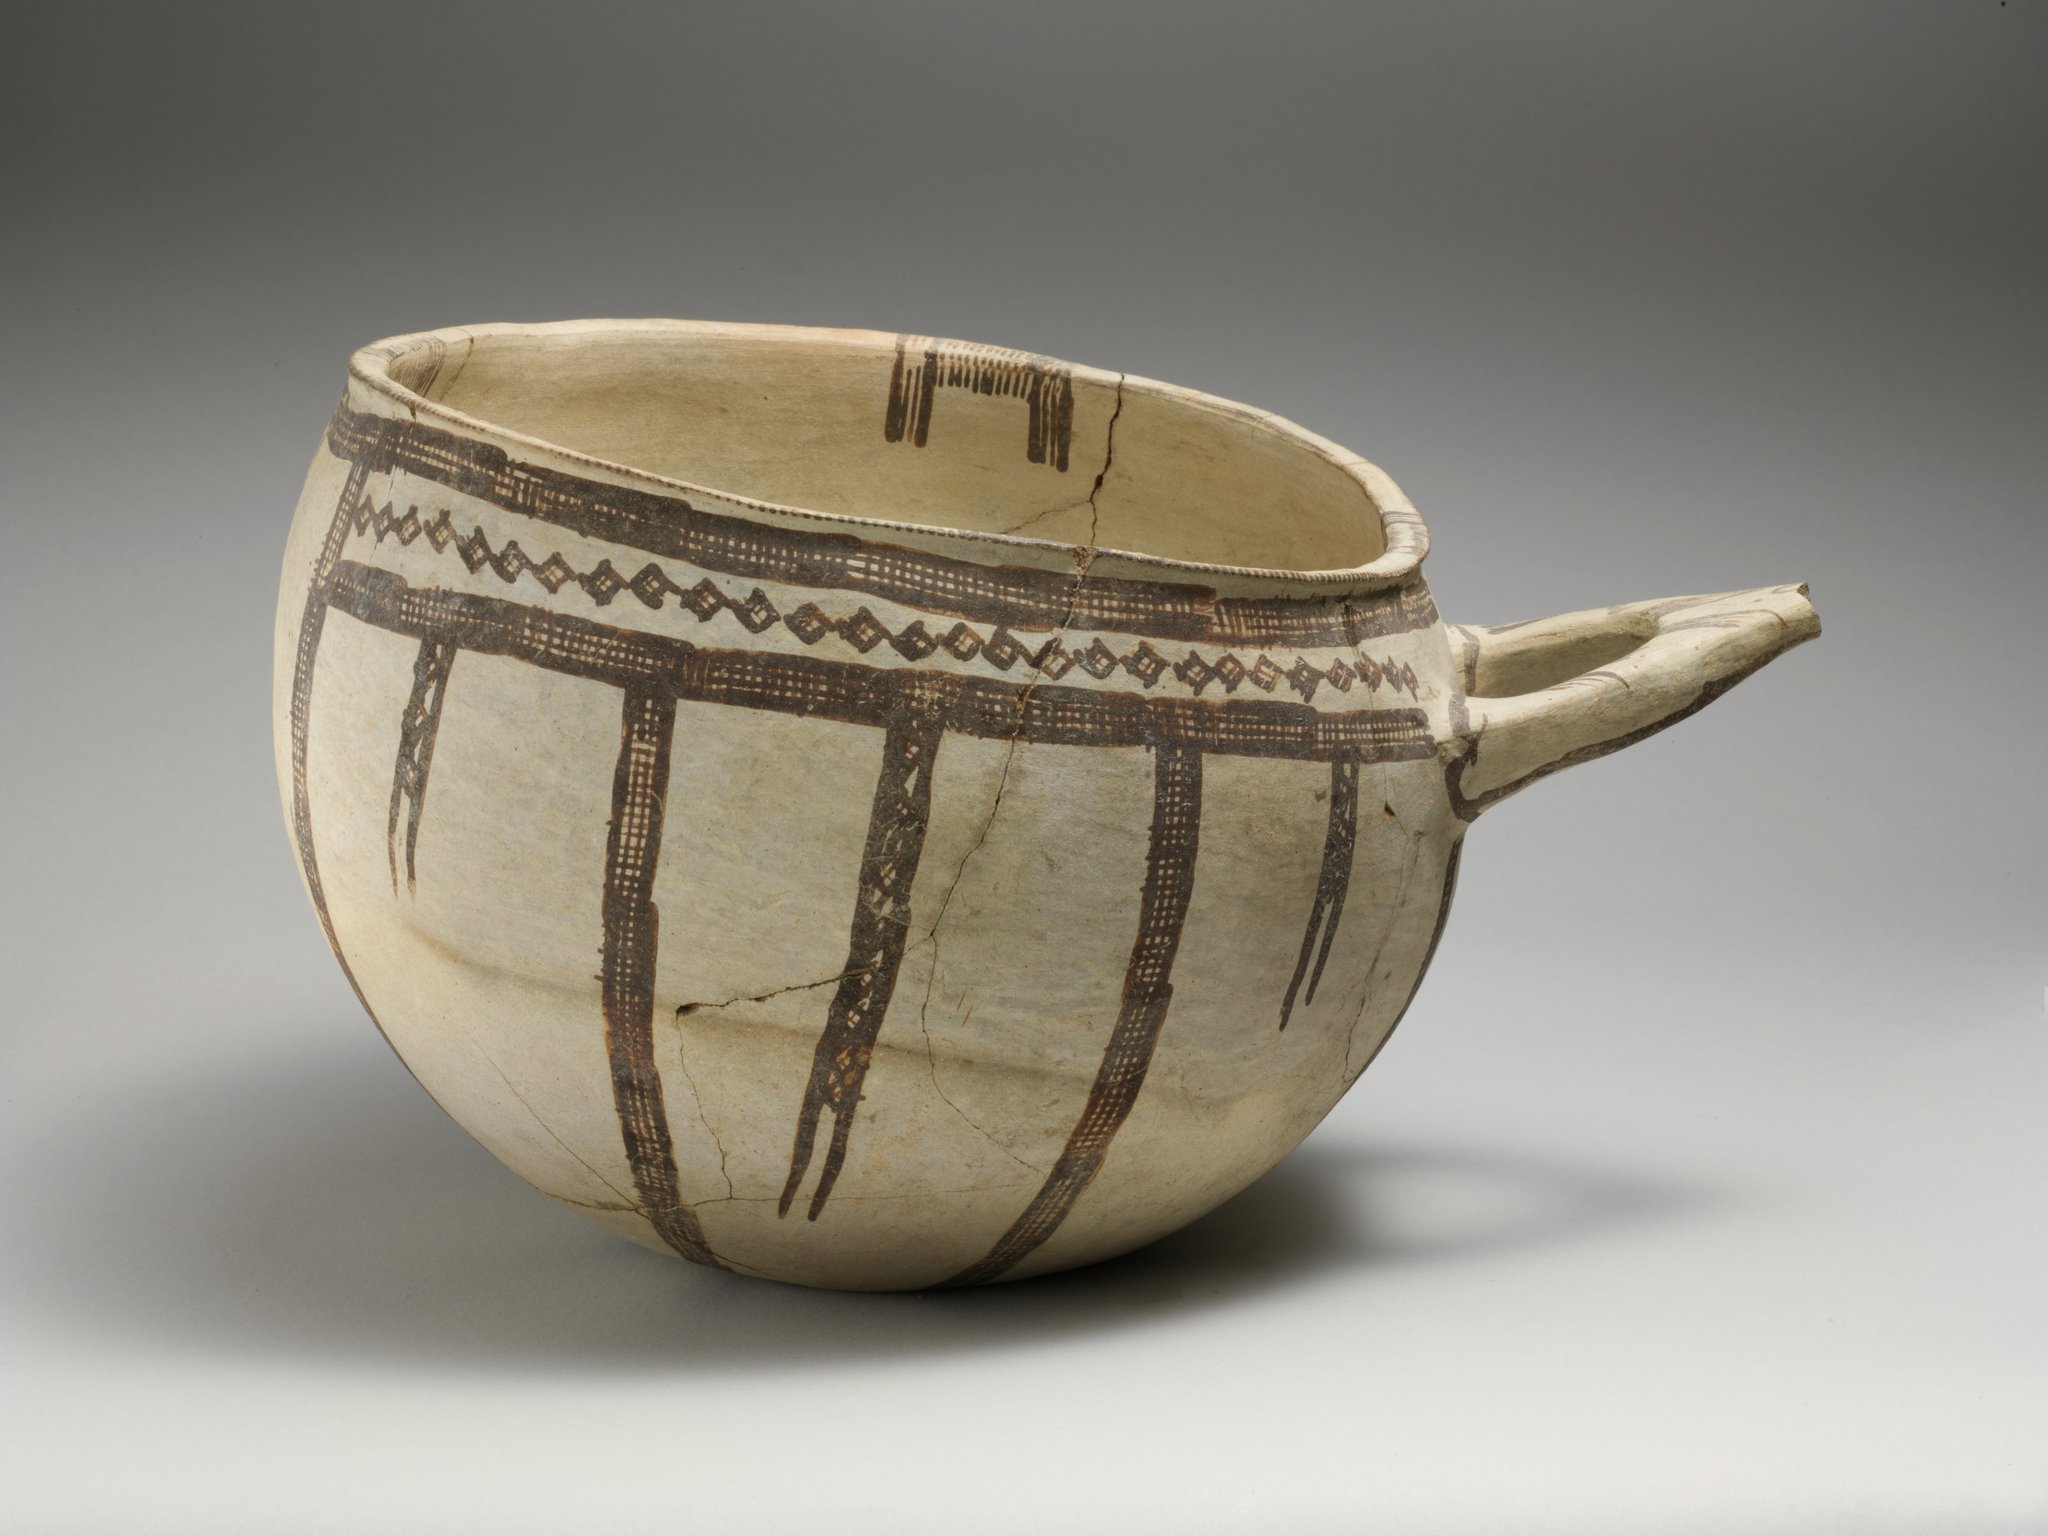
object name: bowl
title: Terracotta bowl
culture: cypriot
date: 1600-1150 BCE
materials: terracotta